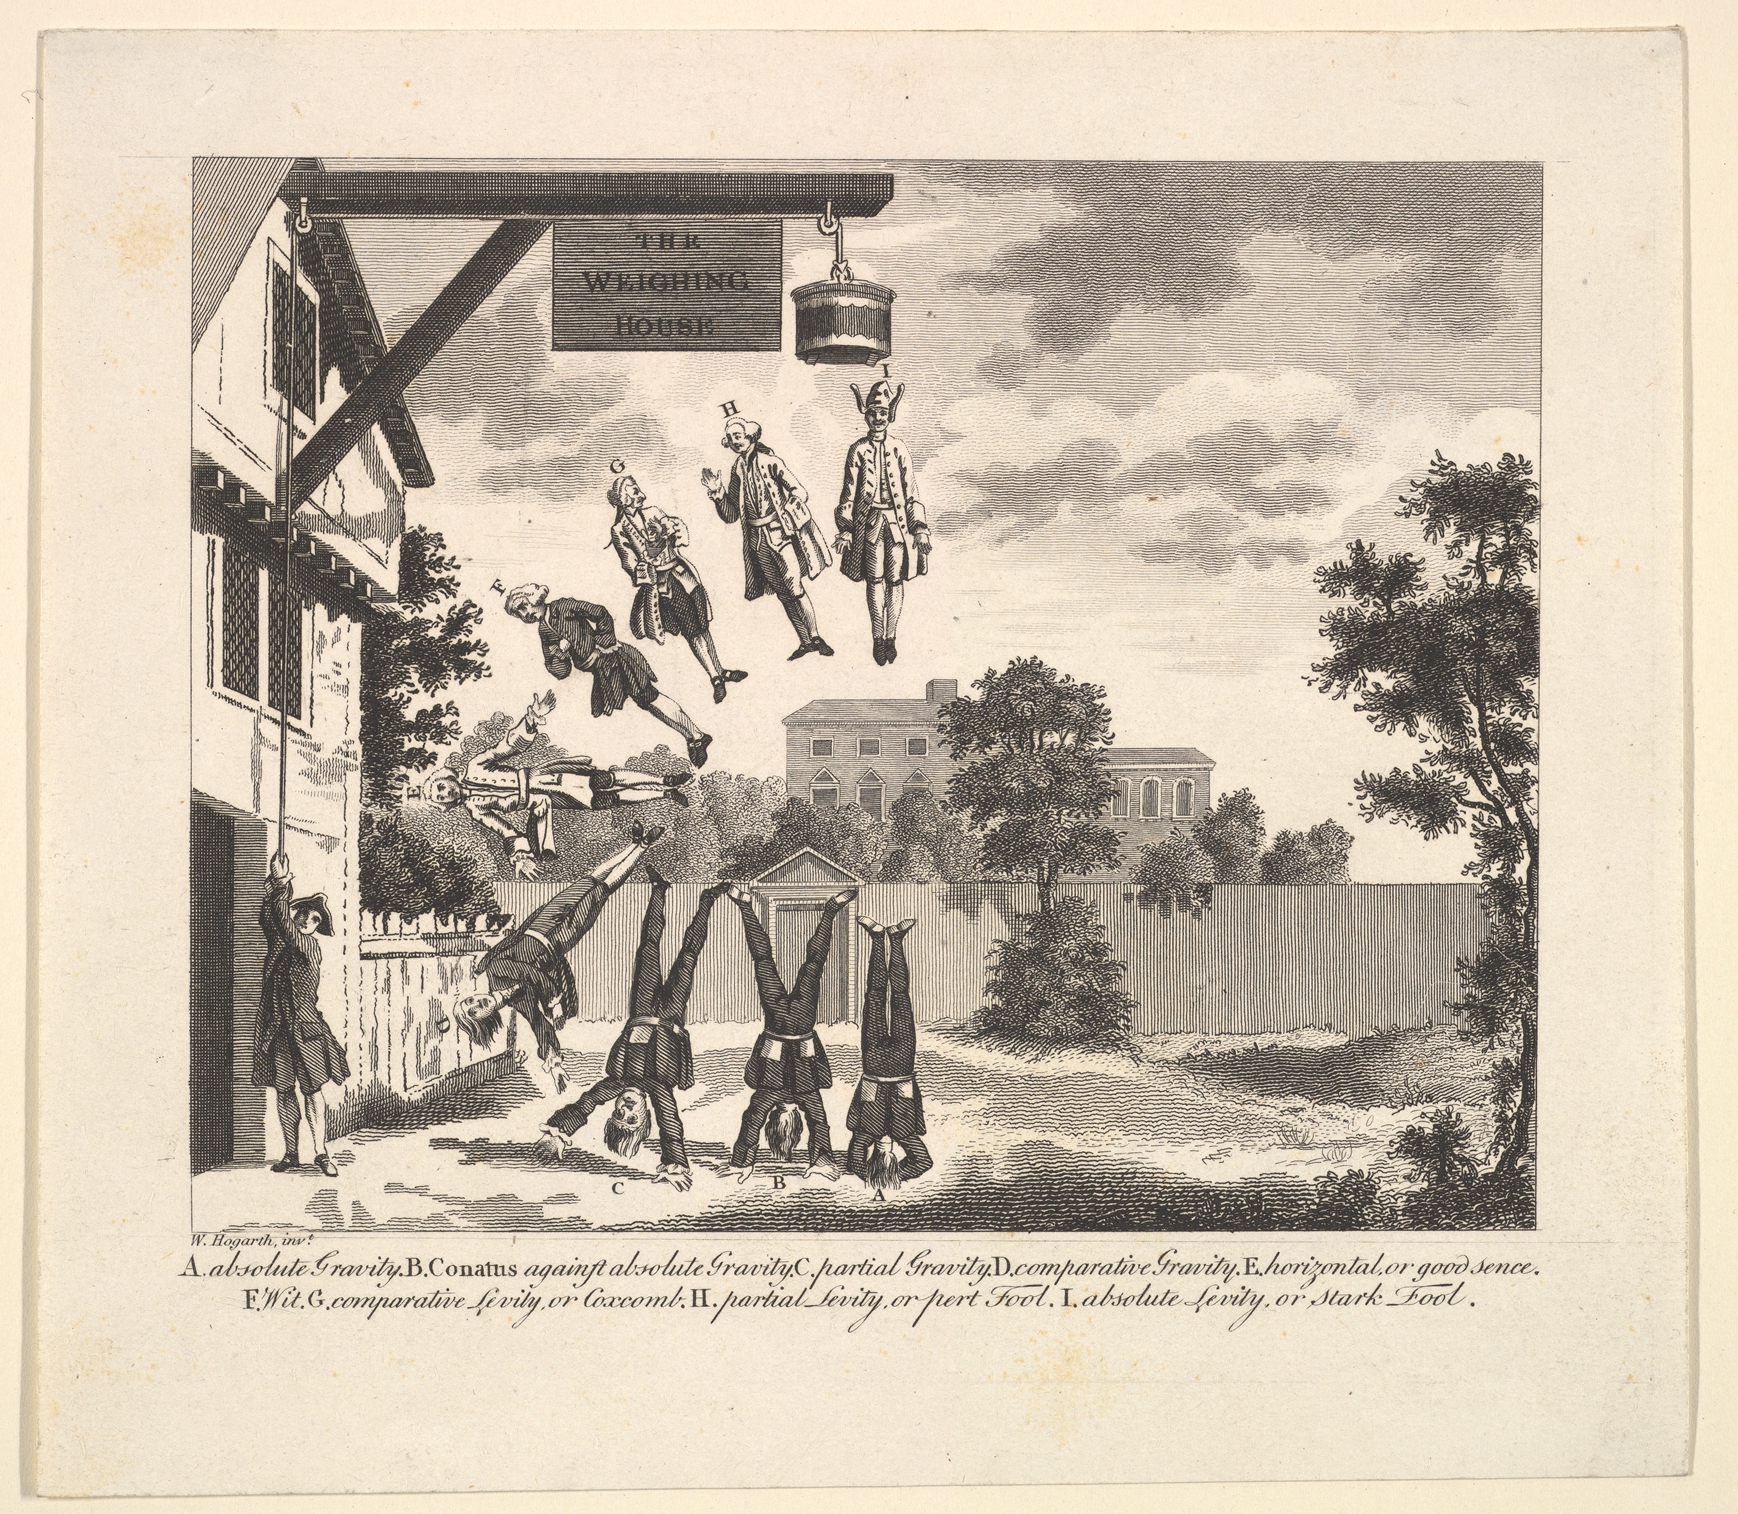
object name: print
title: Frontispiece to Clubbe's Physiognomy (or the Weighing House)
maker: william hogarth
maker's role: artist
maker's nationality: british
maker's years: 1697-1764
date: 1801-1900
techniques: engraving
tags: men